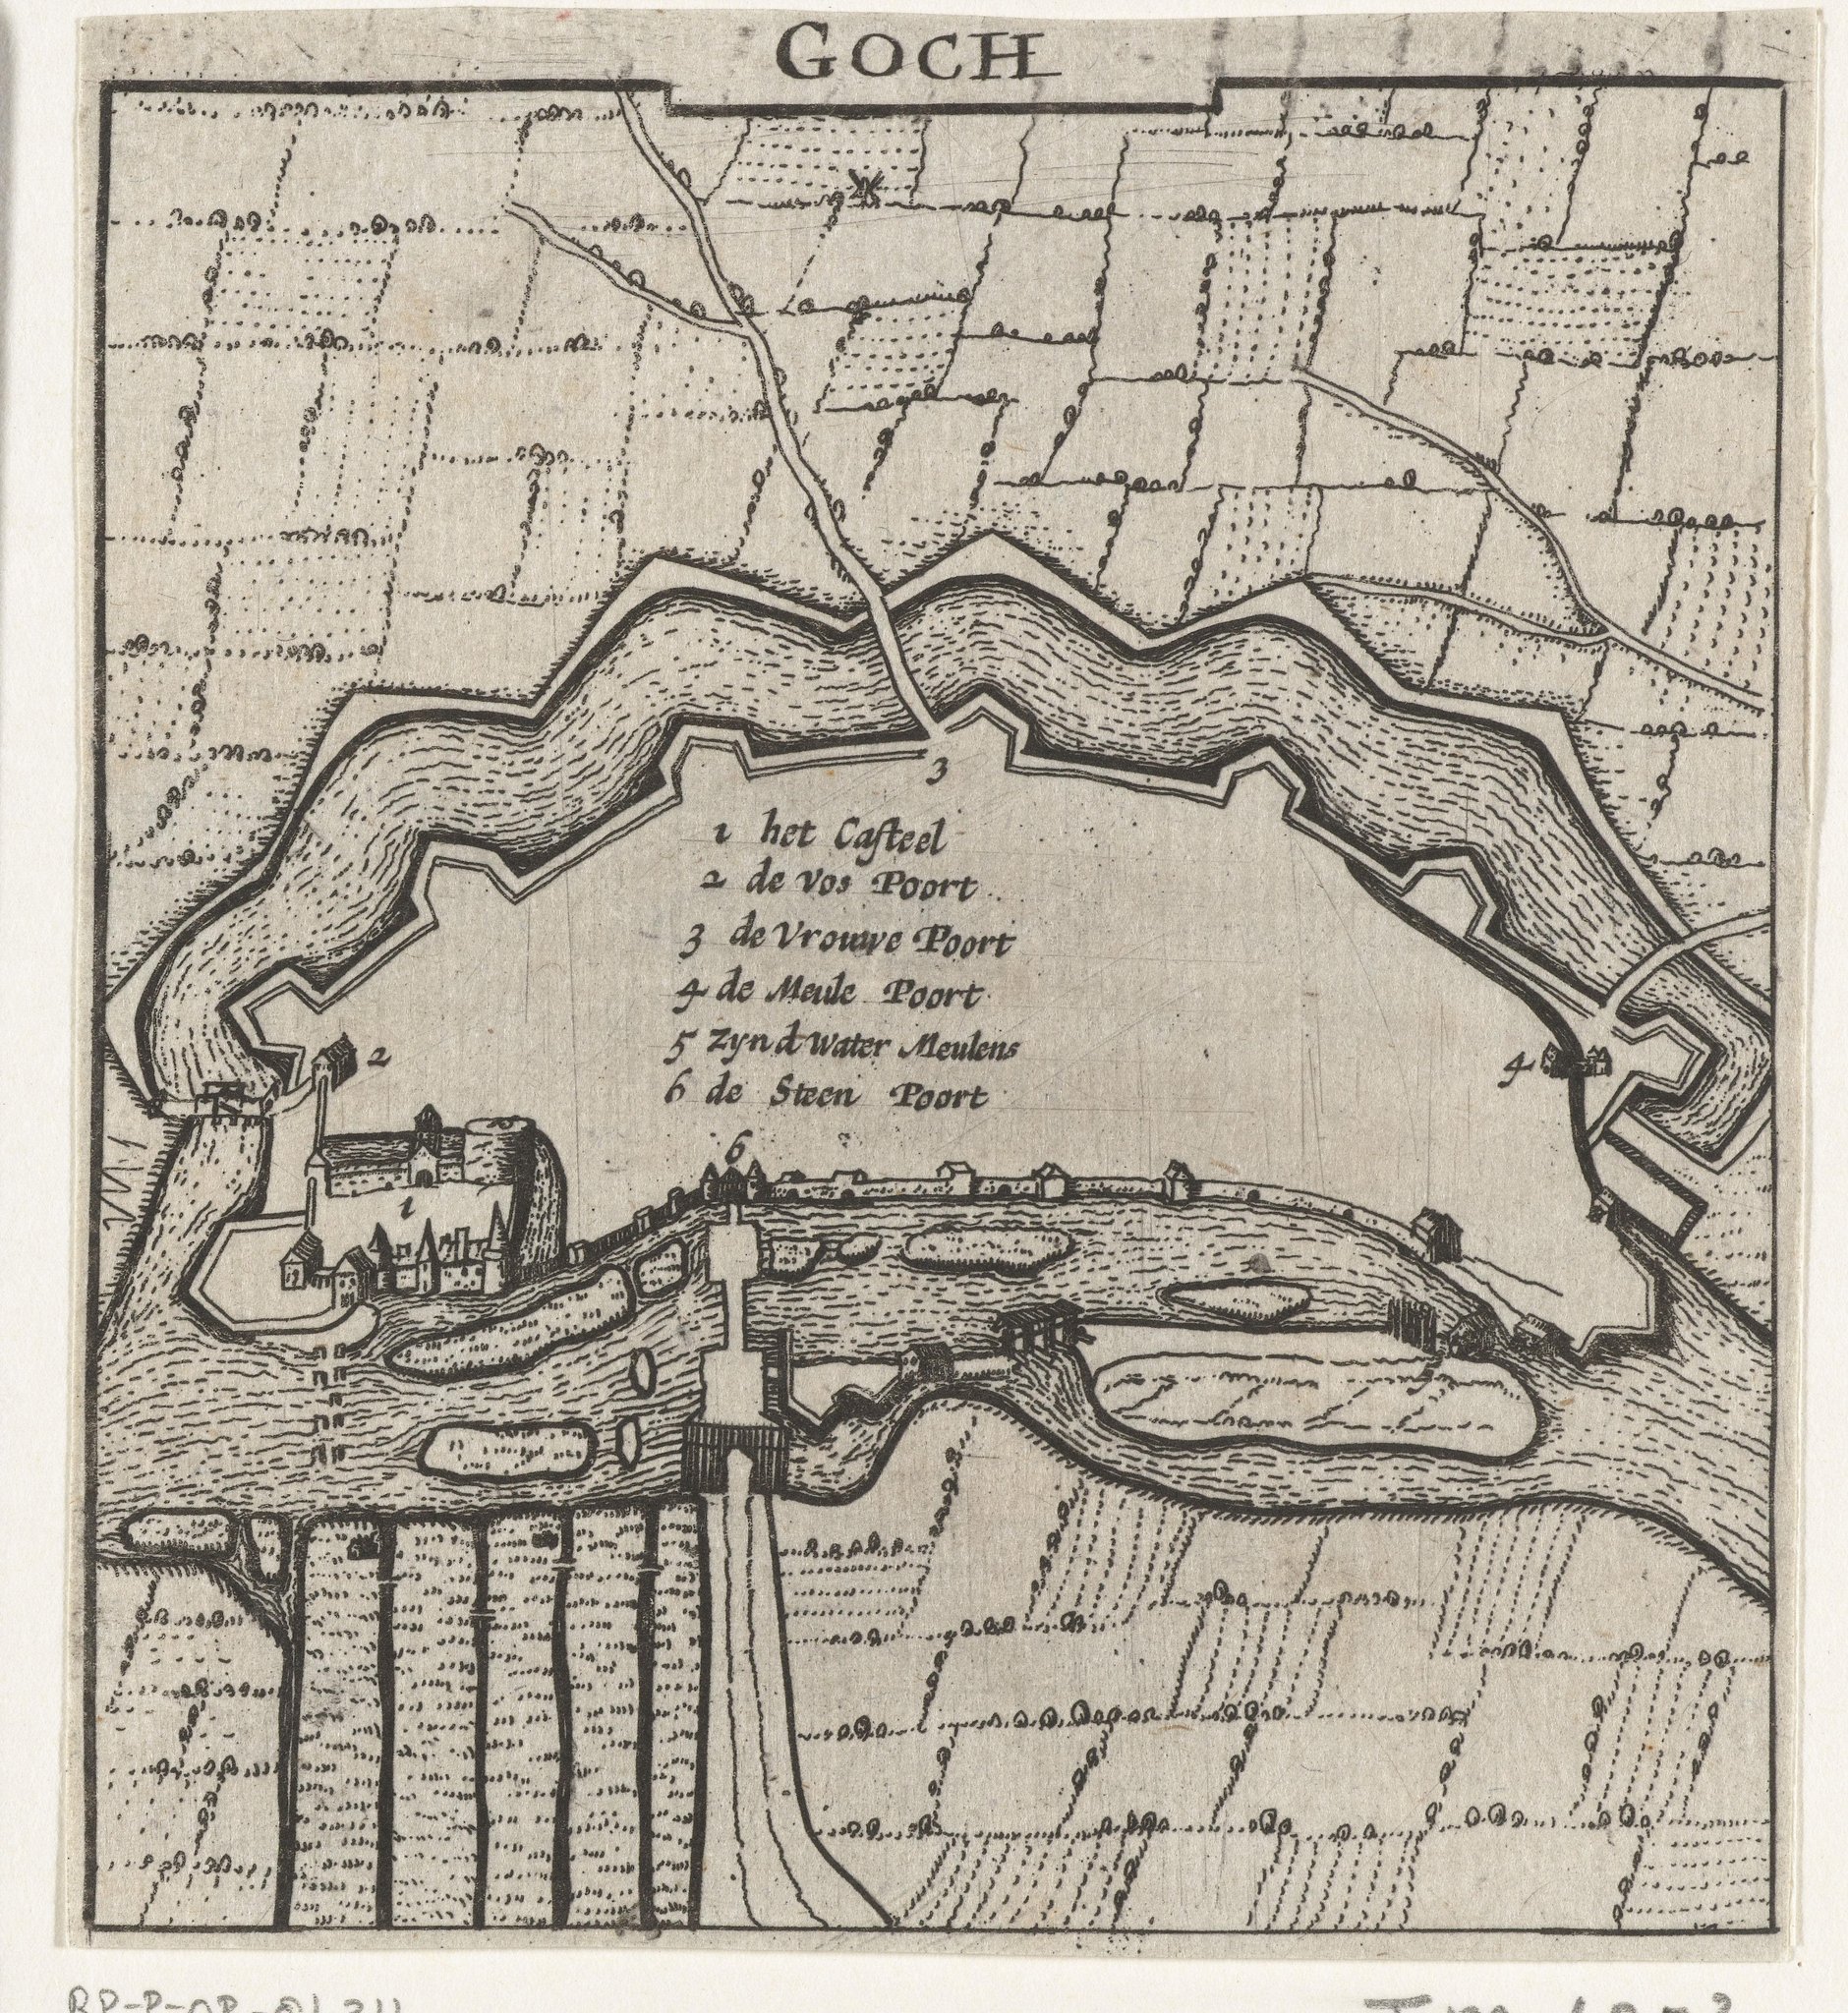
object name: map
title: Goch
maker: Anonymous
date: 1632-1649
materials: paper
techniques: etching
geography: northern netherlands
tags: maps of cities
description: Plattegrond van Goch. Onderdeel van een groep plattegronden van steden, forten en dijken in Brabant veroverd door het Staatse leger onder Frederik Hendrik in de jaren 1631-1632.